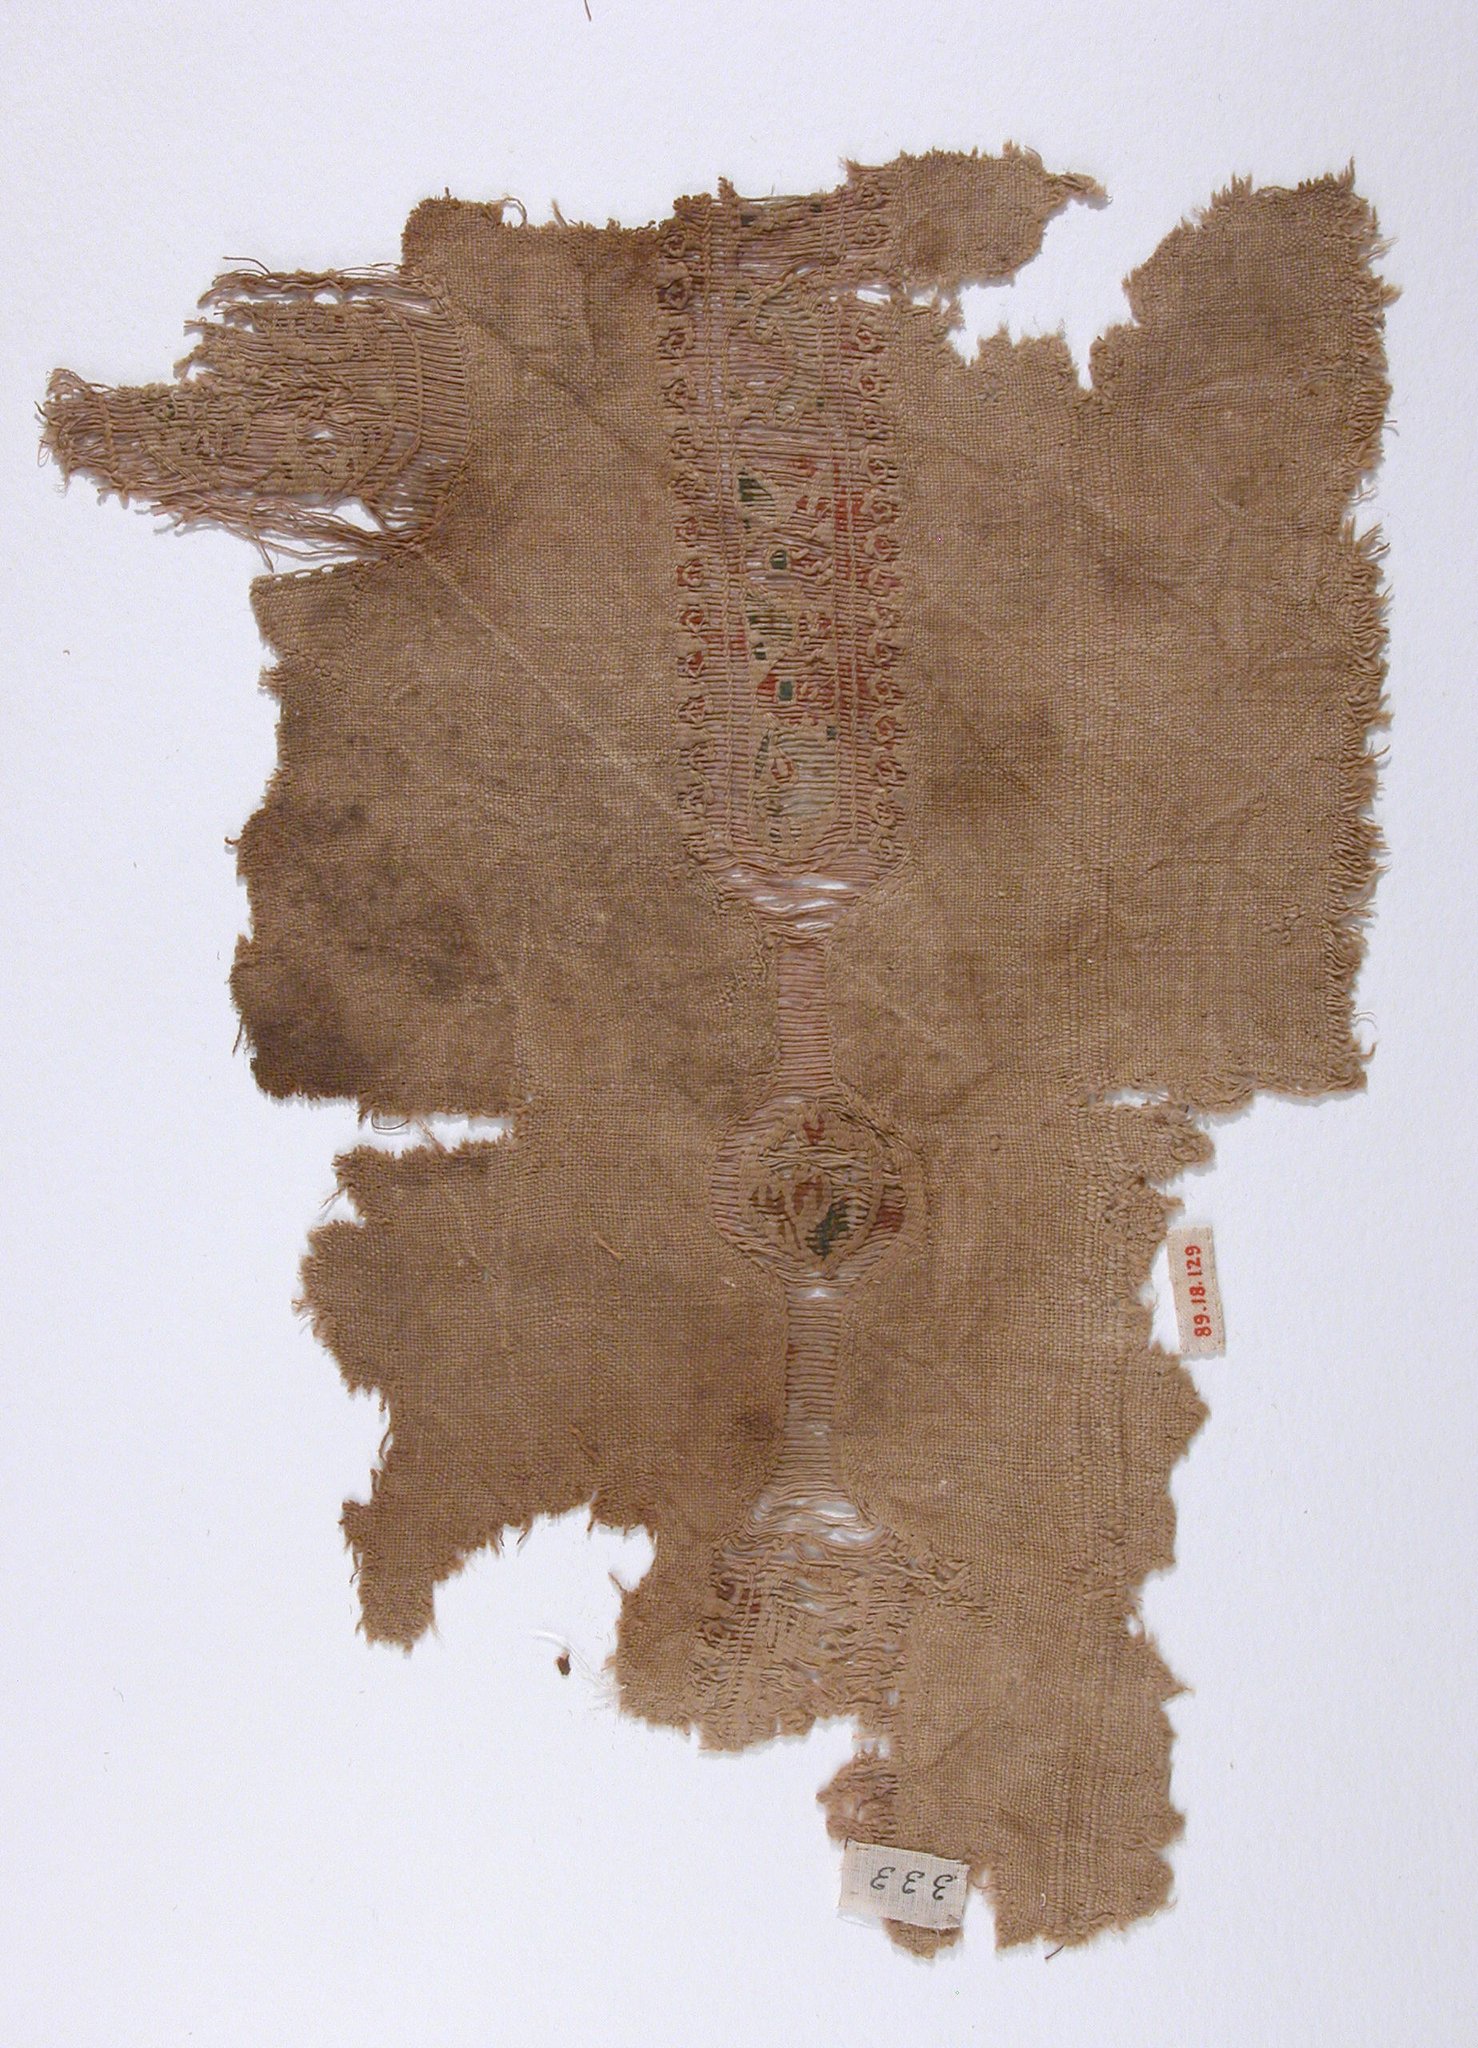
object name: textile fragment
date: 401-600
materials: linen, wool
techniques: weave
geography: egypt